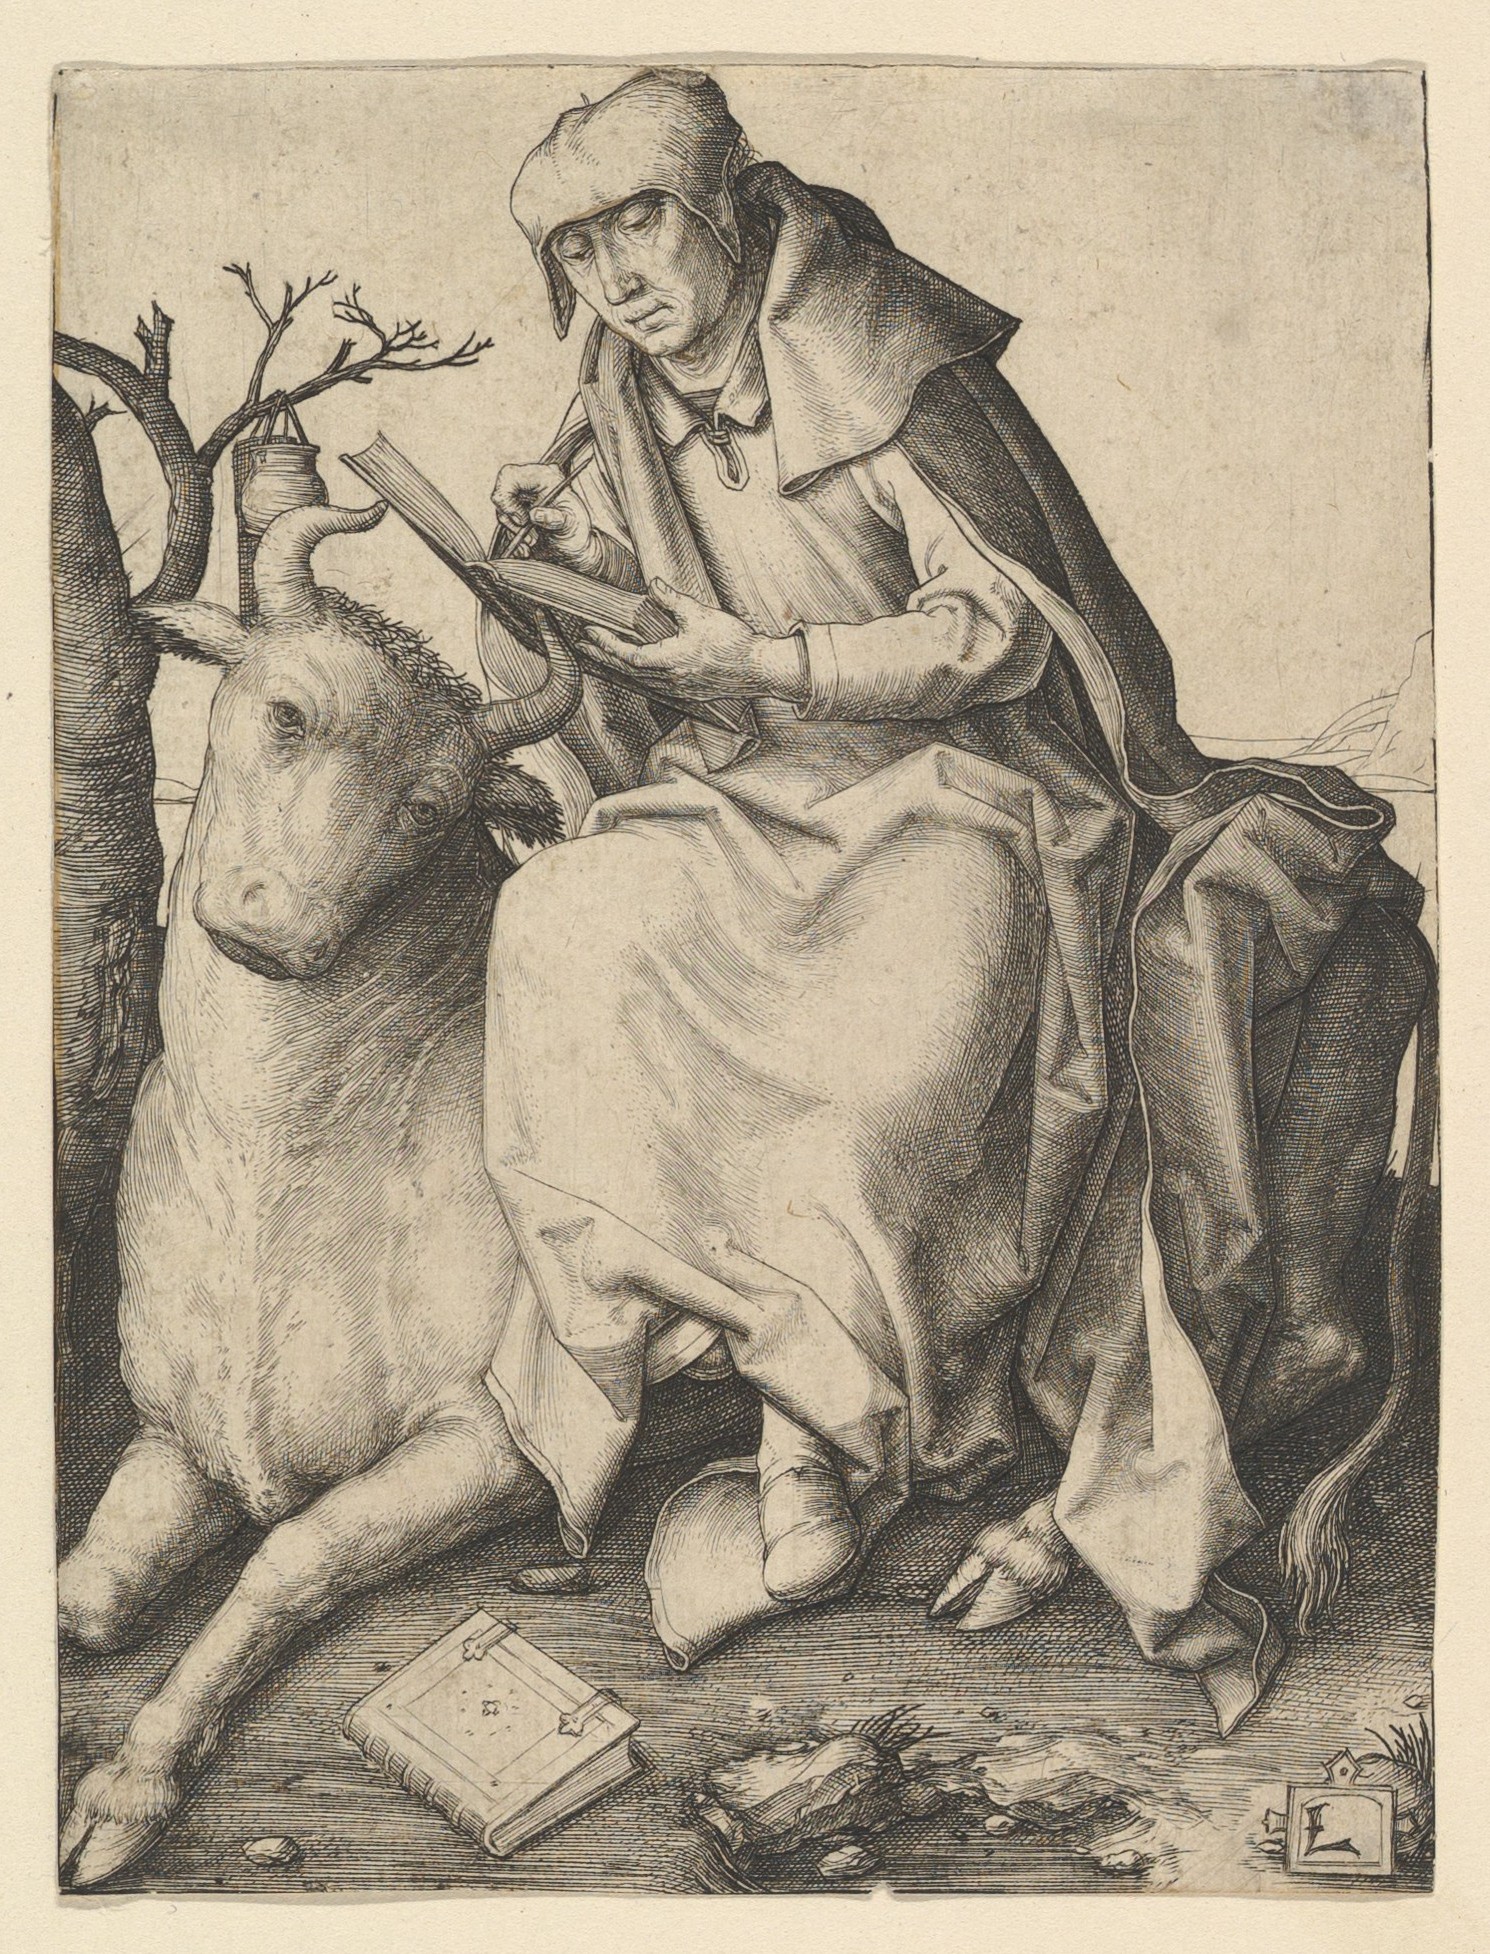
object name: print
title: St. Luke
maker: lucas van leyden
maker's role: artist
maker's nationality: netherlandish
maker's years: 1494-1533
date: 1508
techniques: engraving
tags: men,bulls,saints,writing